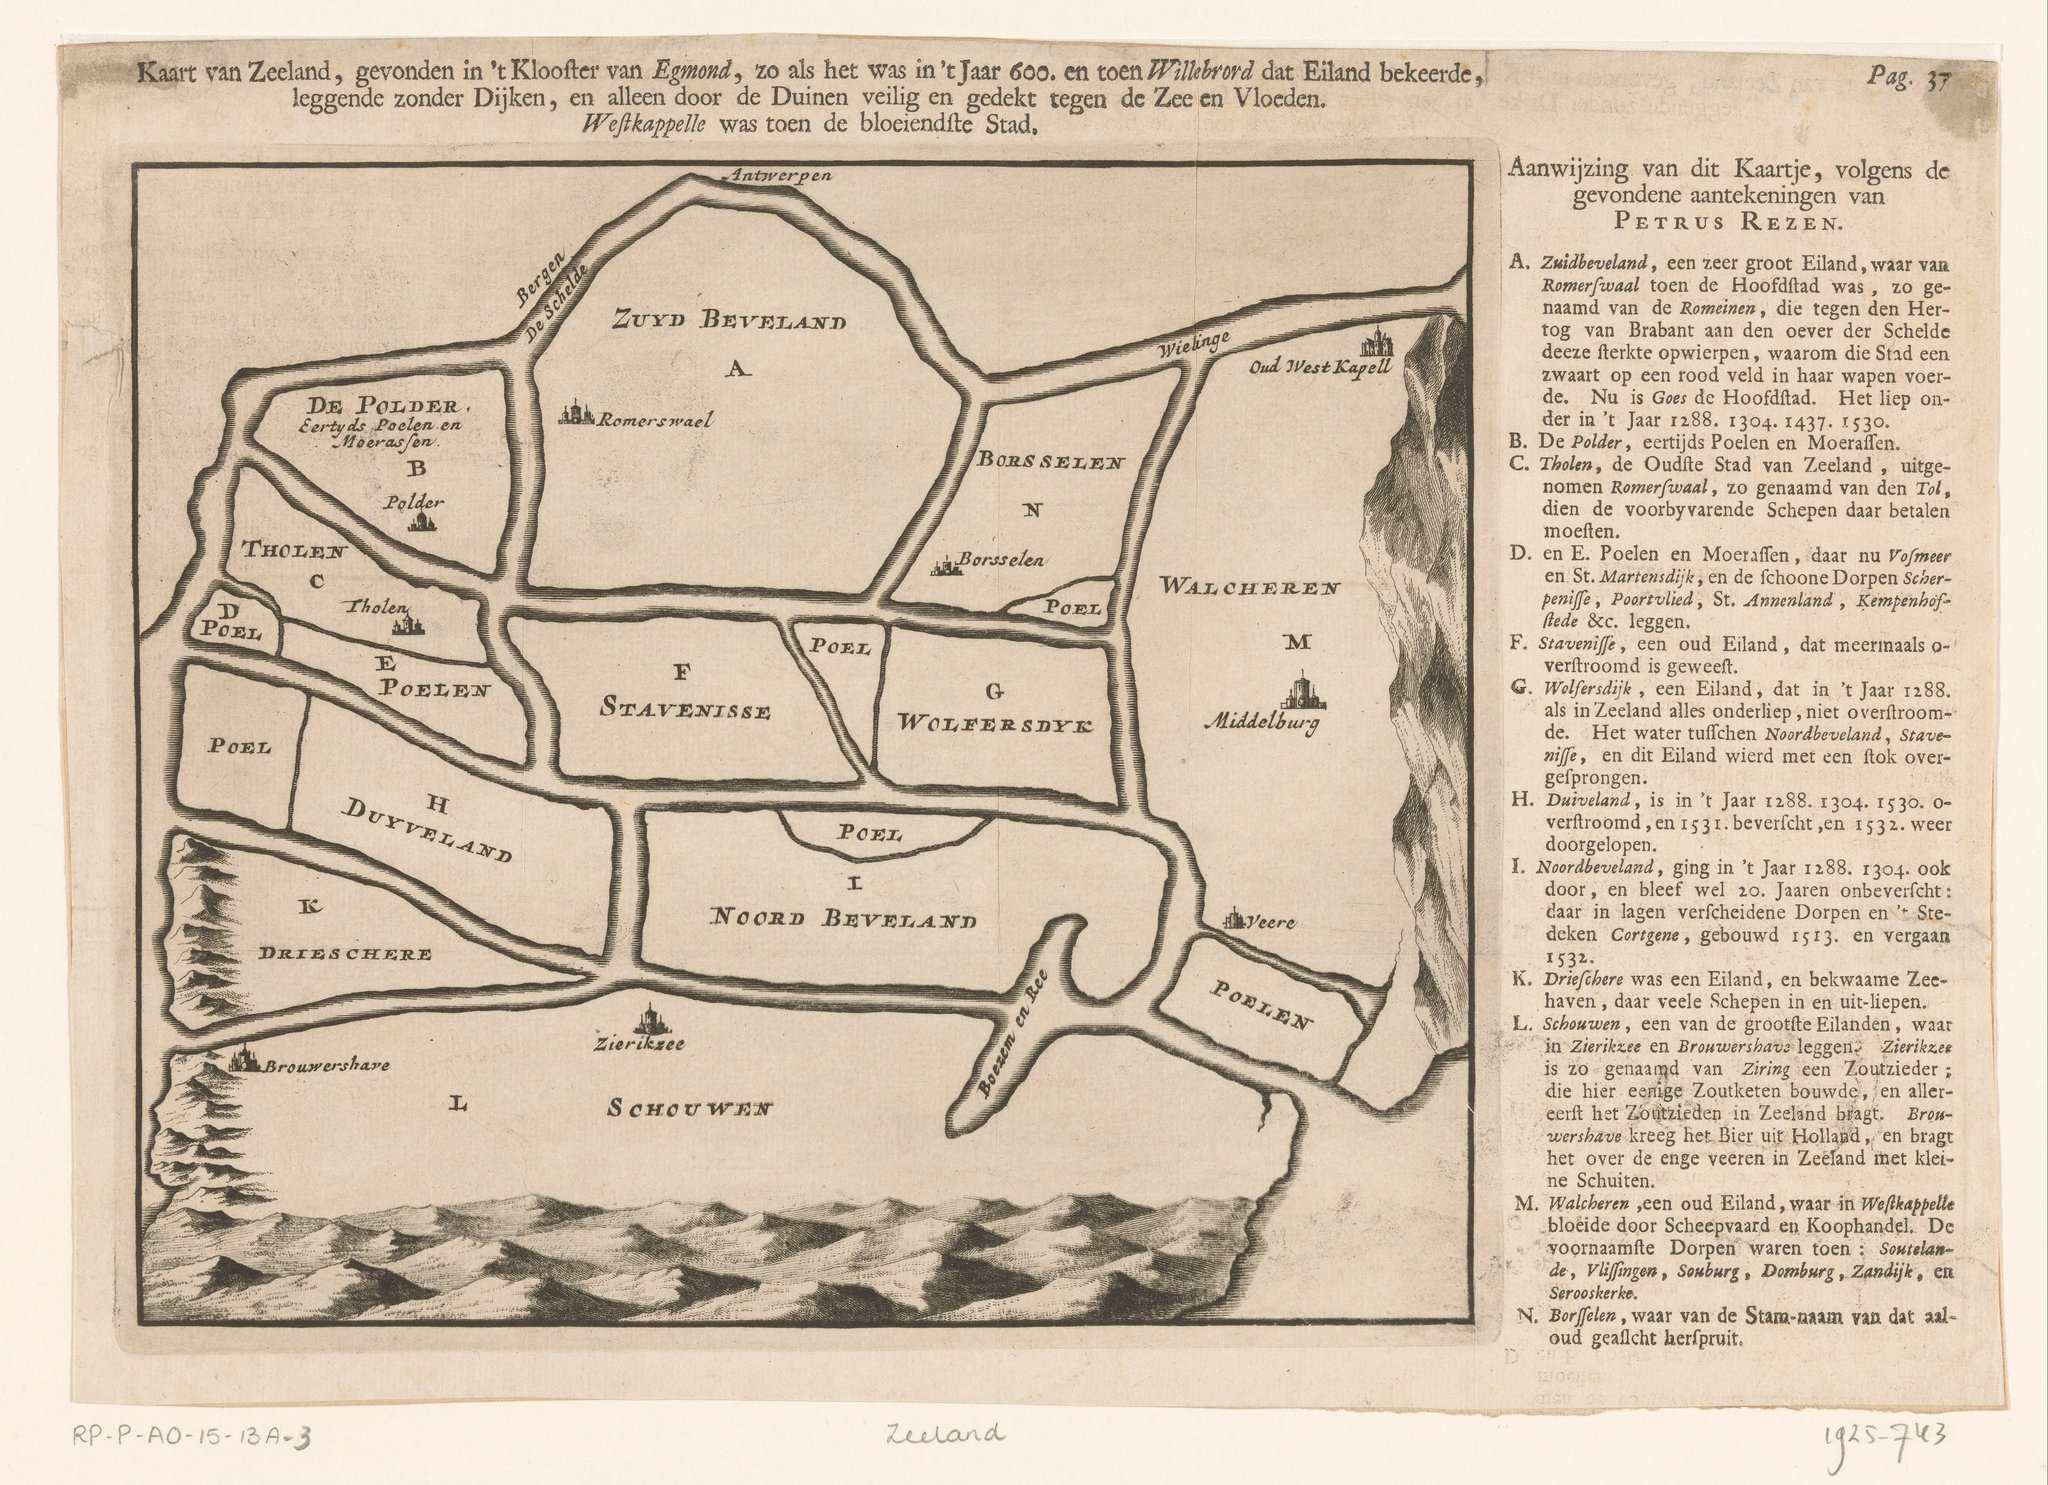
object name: print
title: Kaart van Zeeland, gevonden in 't klooster van Egmond, zo als het was in 't jaar 600. En toen Willebrord dat eiland bekeerde, leggende zonder dijken, en alleen door de duinen veilig en gedekt tegen de zee en vloeden. Westkappelle was toen de bloeiendste stad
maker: Anonymous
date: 1715-1755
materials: paper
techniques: engraving, etching, letterpress printing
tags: maps of separate countries or regions, zeeland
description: Volgens de tekst is deze kaart gekopieerd naar een in het klooster van Egmond gevonden kaart. Zie ook: RP-T-AO-15-2. Prent ook gebruikt in: Gargon, Mattheus. Walchersche arkadia, waar in op een zoetvoerigen trant (…). 2 delen. Leiden: Samuel Luchtmans, 1715-1717, dl. 1 (1715), p. 37. En in: Gargon, Mattheus. Walchersche arkadia, waar in op een zoetvoerigen trant (…). 2 delen. Leiden: Samuel Luchtmans en Zoon, 1746, dl. 1, p. 37. En in: Gargon, Mattheus. Walchersche arkadia, waar in op een zoetvoerigen trant (…). 2 delen. Middelburg: M.H. en A.L. Callenfels, S. Mandelgreen, P. Gillissen en L. Taillefert, 1755, dl. 1, p. 37.